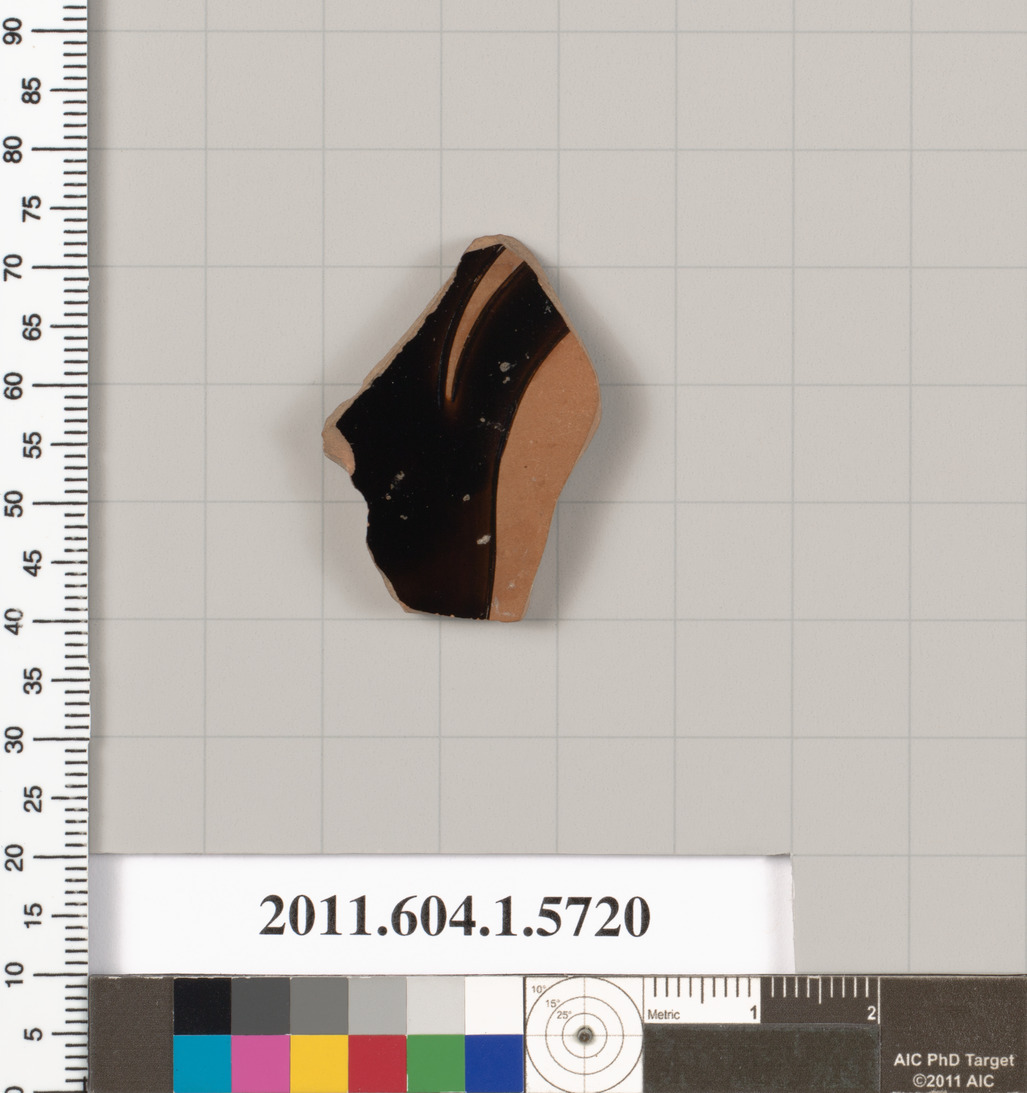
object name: kylix fragment, eye cup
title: Terracotta fragment of a kylix: eye-cup (drinking cup)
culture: greek, attic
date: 525-510 BCE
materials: terracotta